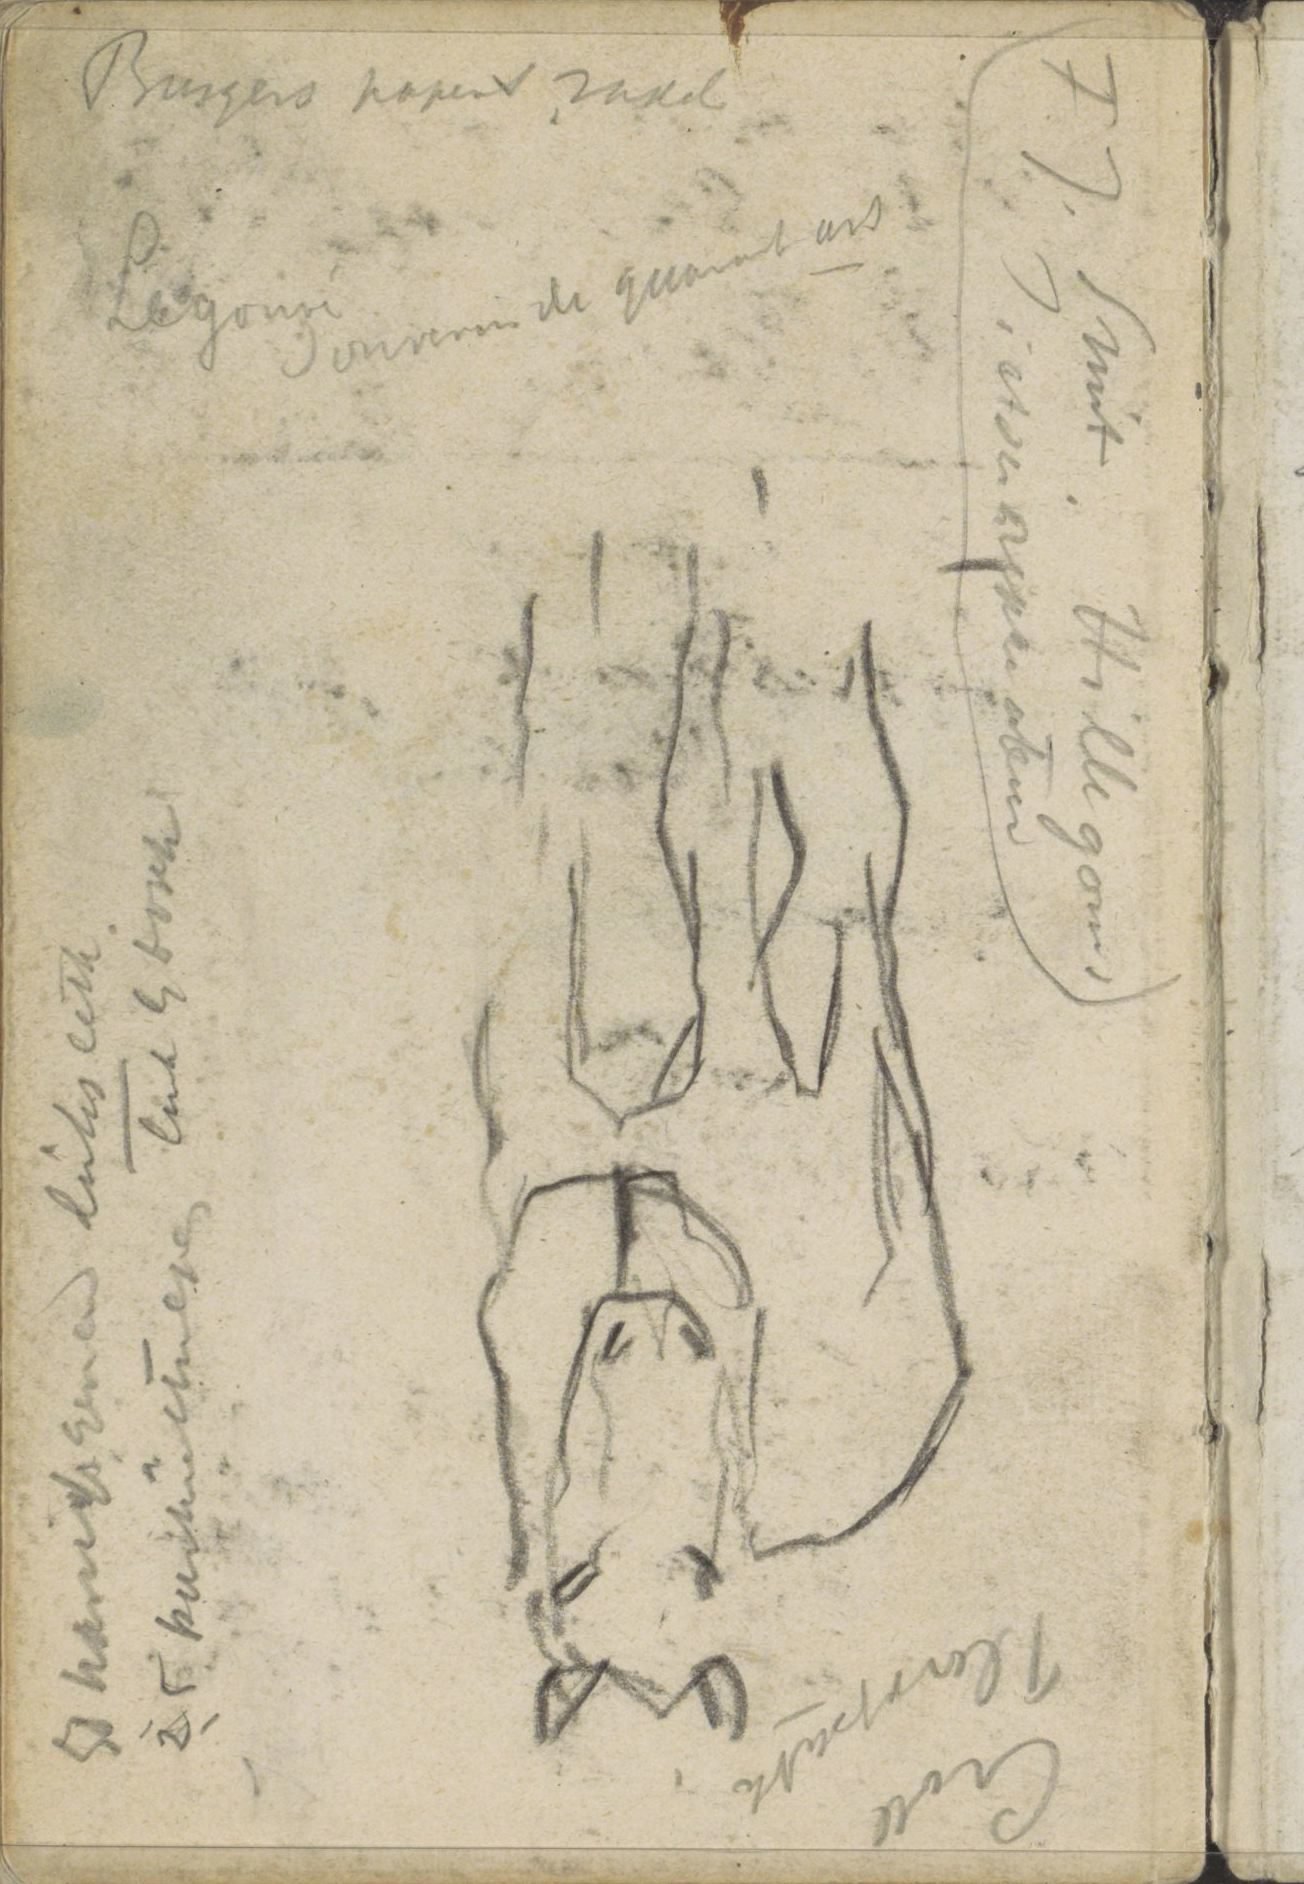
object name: sketchbook leaf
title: Paard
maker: george hendrik breitner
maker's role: draughtsman, painter, print maker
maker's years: 1857-1923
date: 1902-1914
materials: chalk, paper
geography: amsterdam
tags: horse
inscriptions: annotation: ‘F.J. Smit. Hillegom’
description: Paard. Pagina 93 uit een schetsboek met 46 bladen vervaardigd te Noord-Holland en Utrecht.